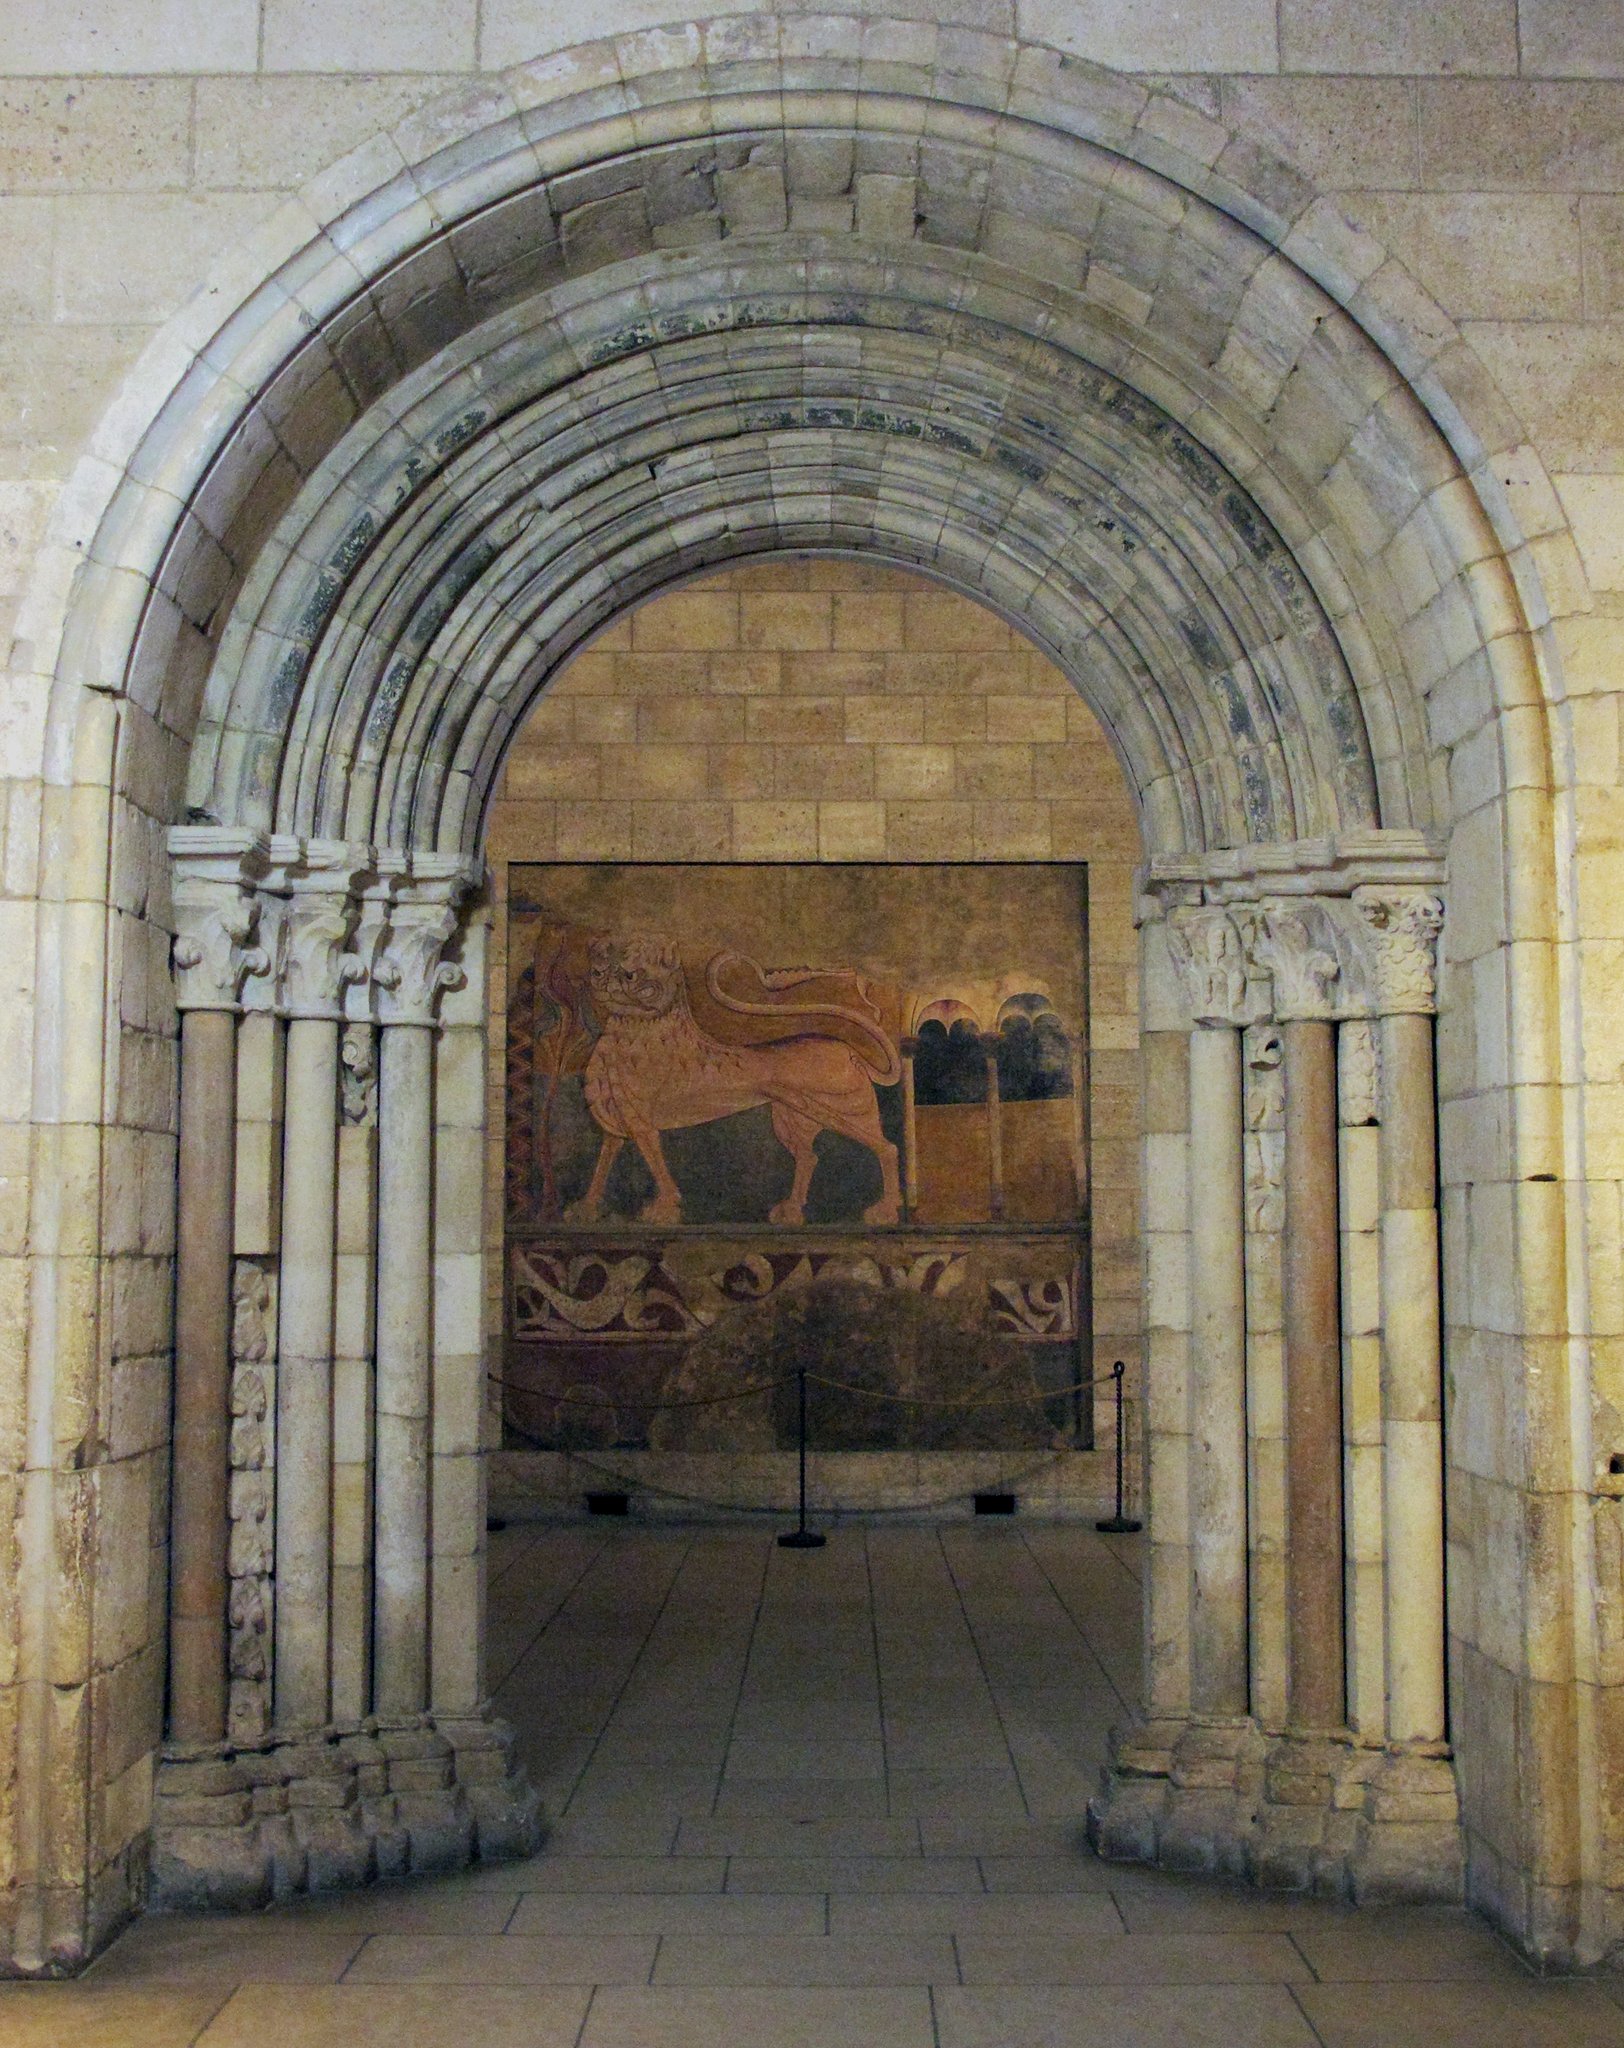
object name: doorway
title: Doorway from Abbey of Notre-Dame at Nevers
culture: french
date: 1201-1300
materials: limestone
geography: france